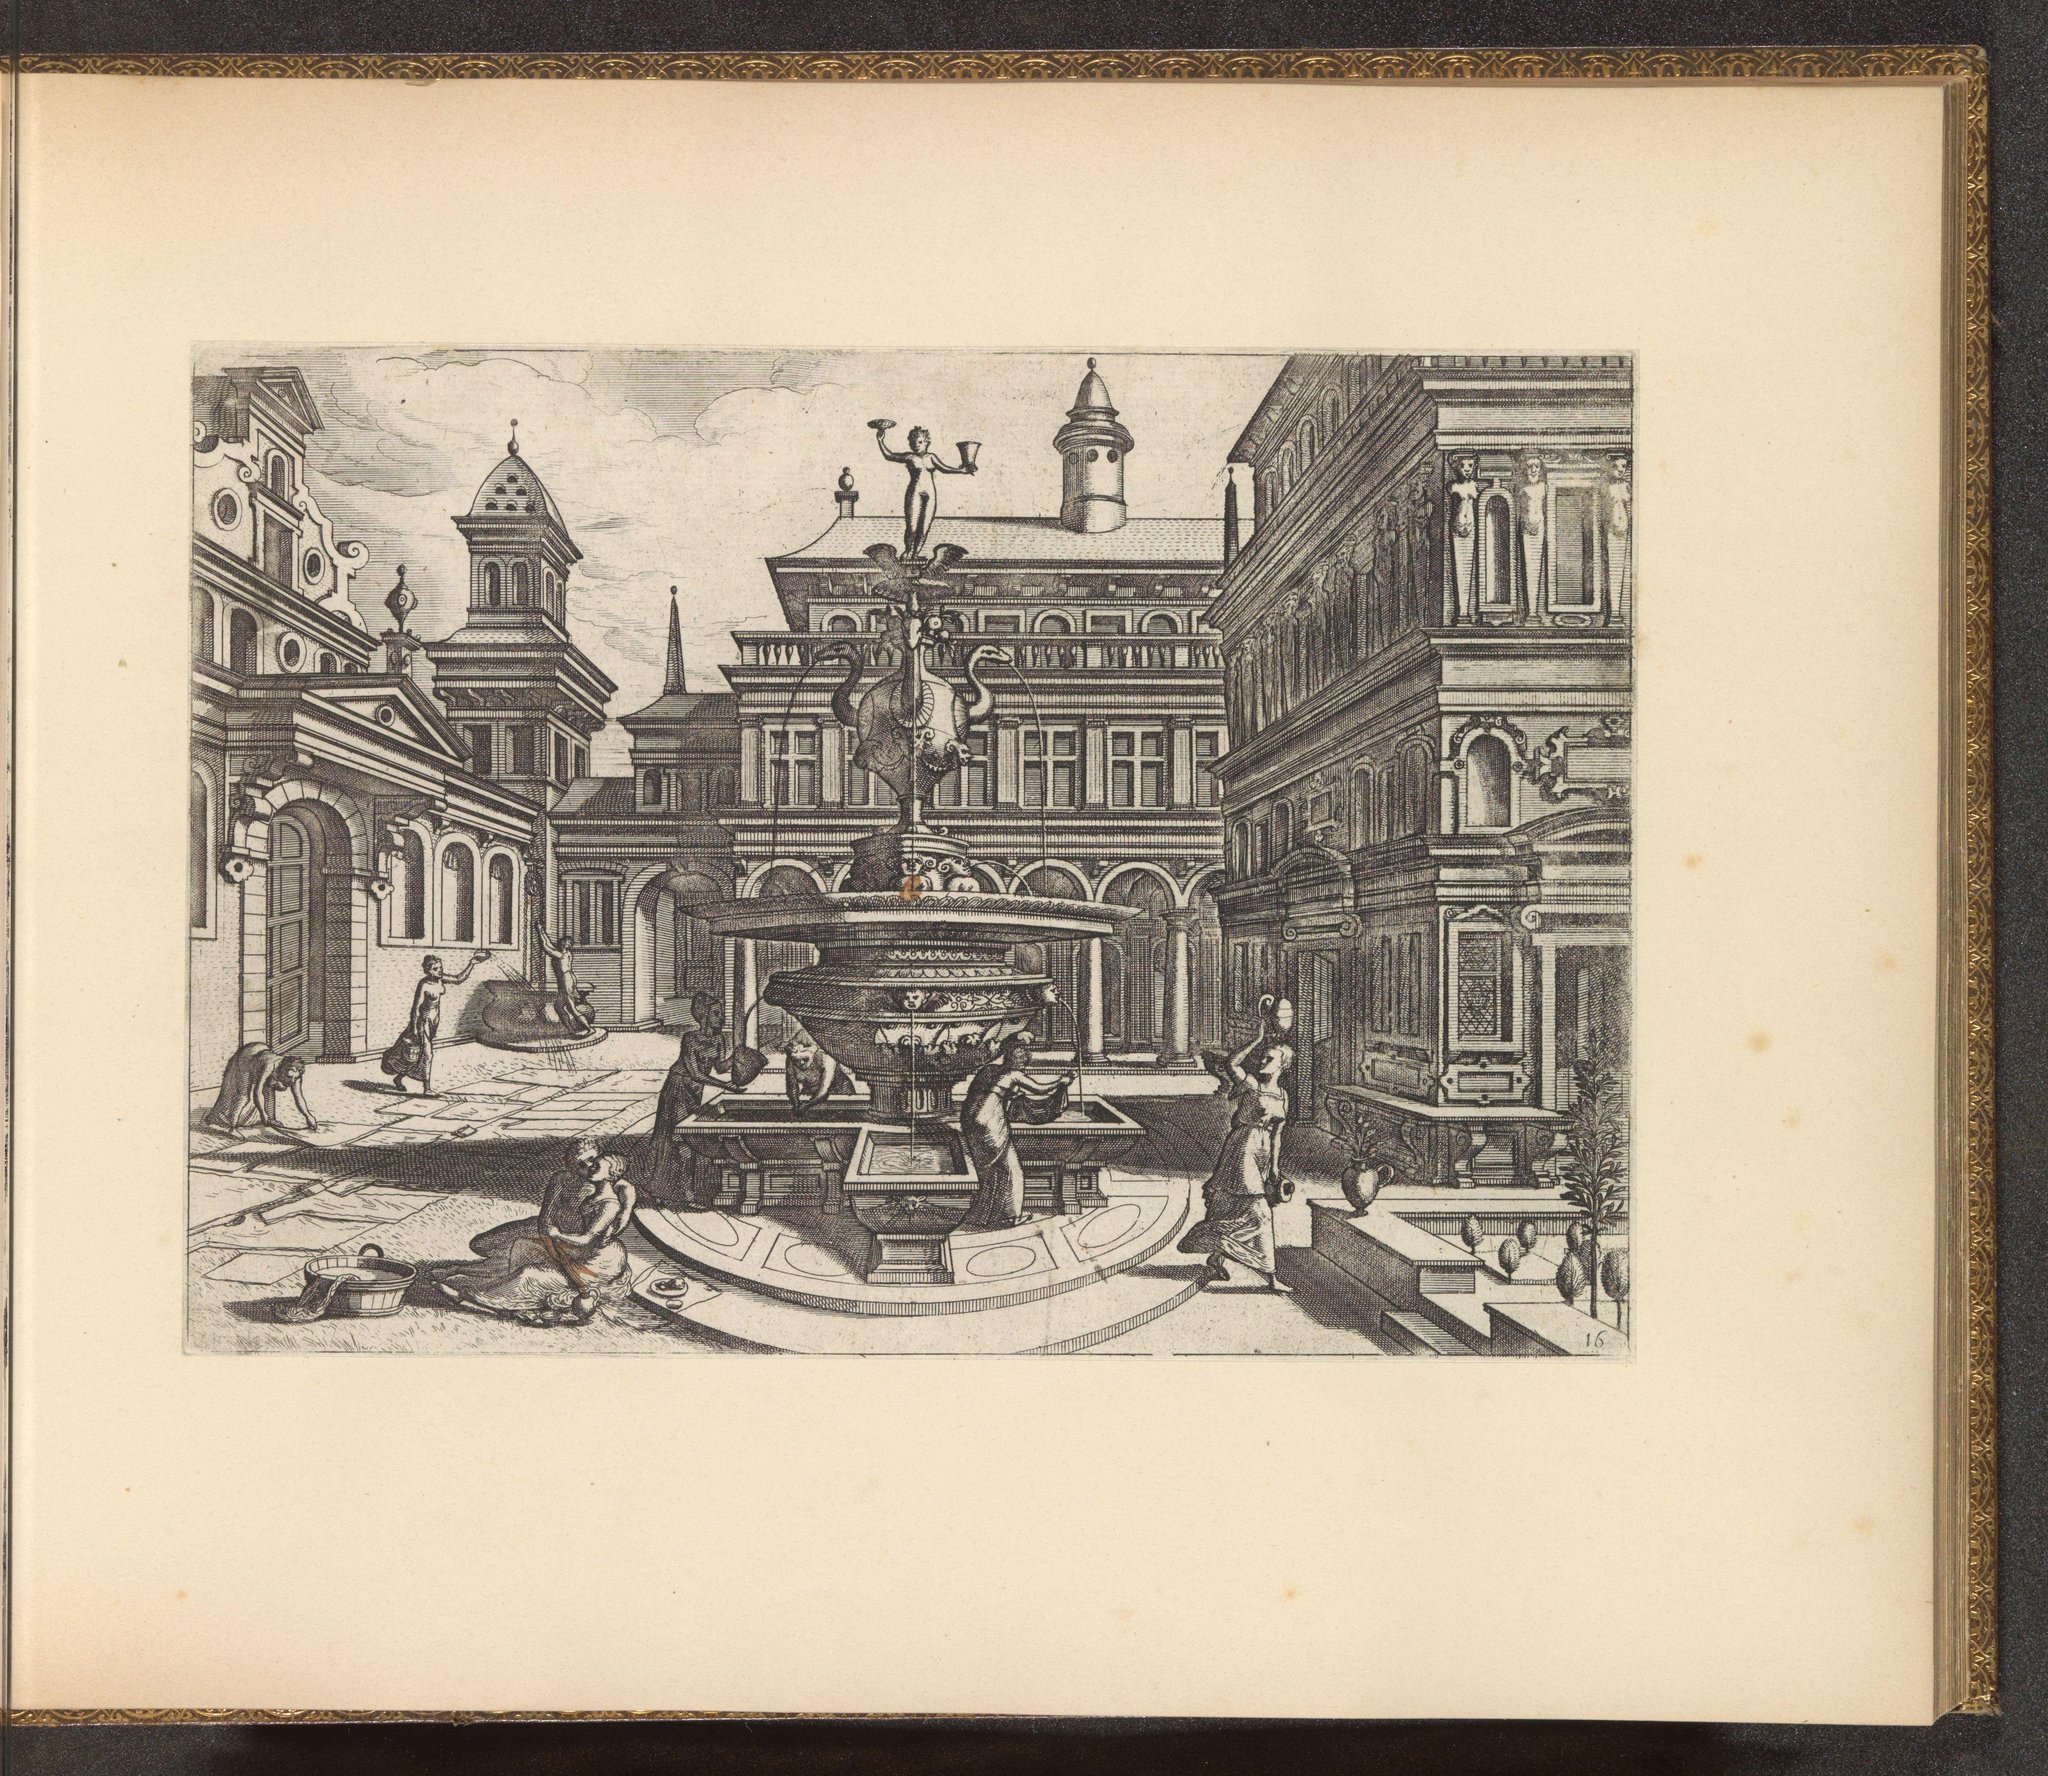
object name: print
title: Artis Perspectiva (...)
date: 1600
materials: paper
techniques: etching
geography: antwerp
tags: piece of sculpture, reproduction of a piece of sculpture, ornamental fountain, civic architecture; edifices; dwellings, street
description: Plein met een vaasvormige fontein in drie verdiepingen. De vaas staat in een kruisvormig bekken en wordt bekroond door een bol waaruit water spuwende vogelkoppen steken. De fontein wordt bekroond door een beeld van een vrouw met een tazza en een drinkbeker in de handen. Links op de voorgrond een minnekozend paar. Op de achtergrond vrouwen die was te drogen leggen. De prent maakt deel uit van een album.